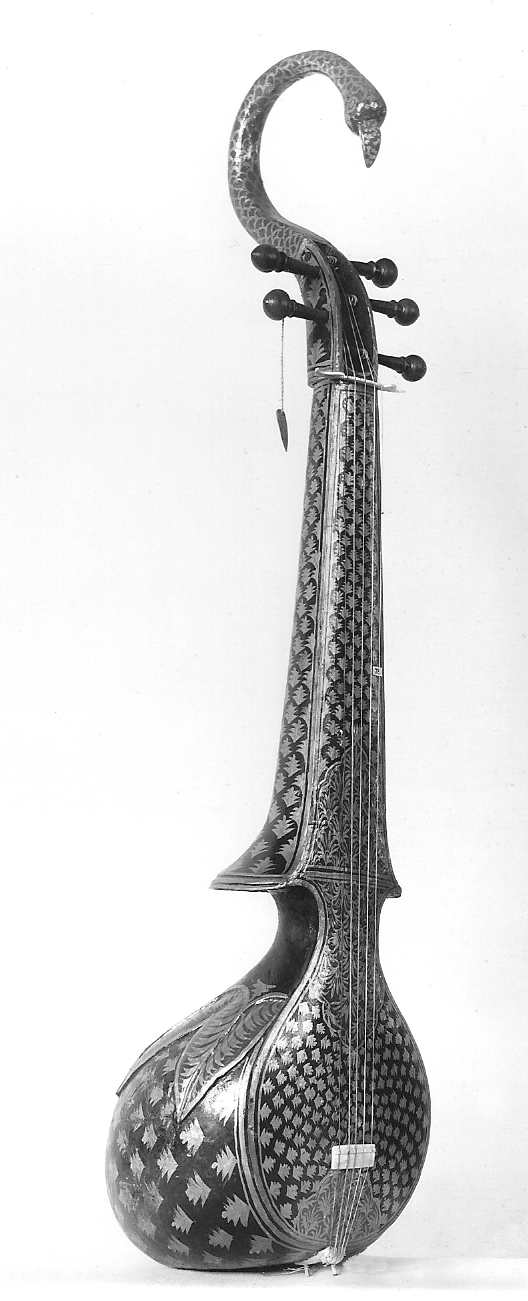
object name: sursanga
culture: indian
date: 1880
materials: bone, ivory, metal, wood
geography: india